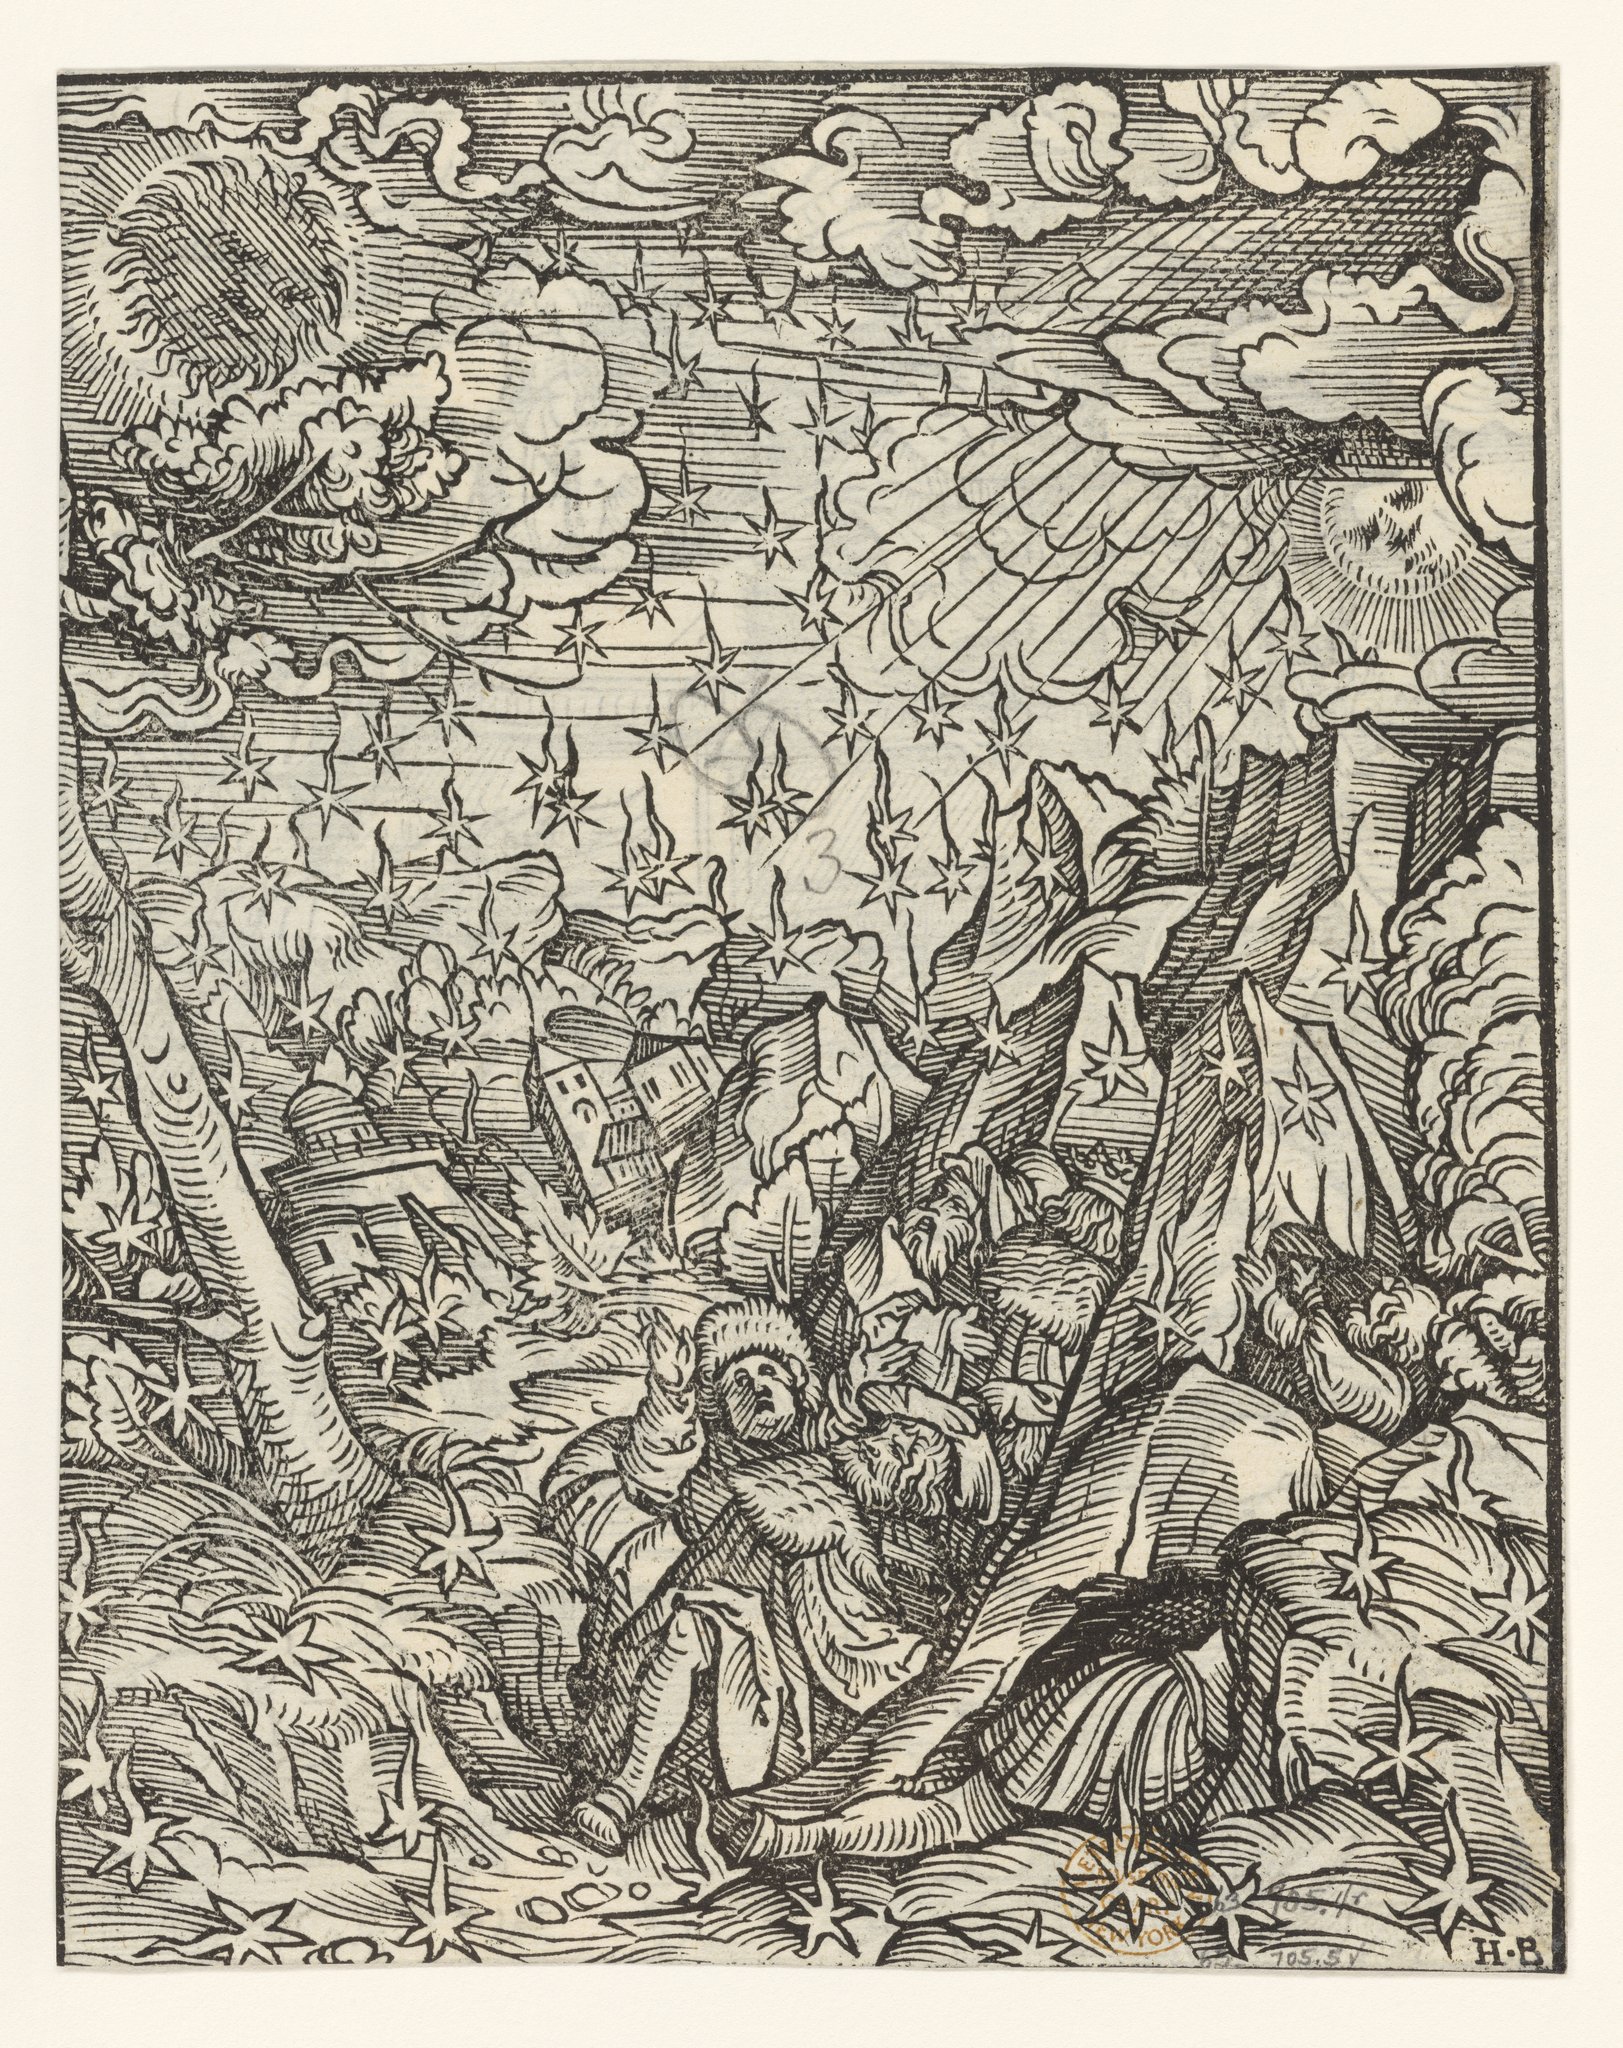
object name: print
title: The Fire-Rain, plate 5 from The Apocalypse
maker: hans burgkmair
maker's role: artist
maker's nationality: german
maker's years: 1473-1531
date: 1523-1524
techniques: woodcut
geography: germany